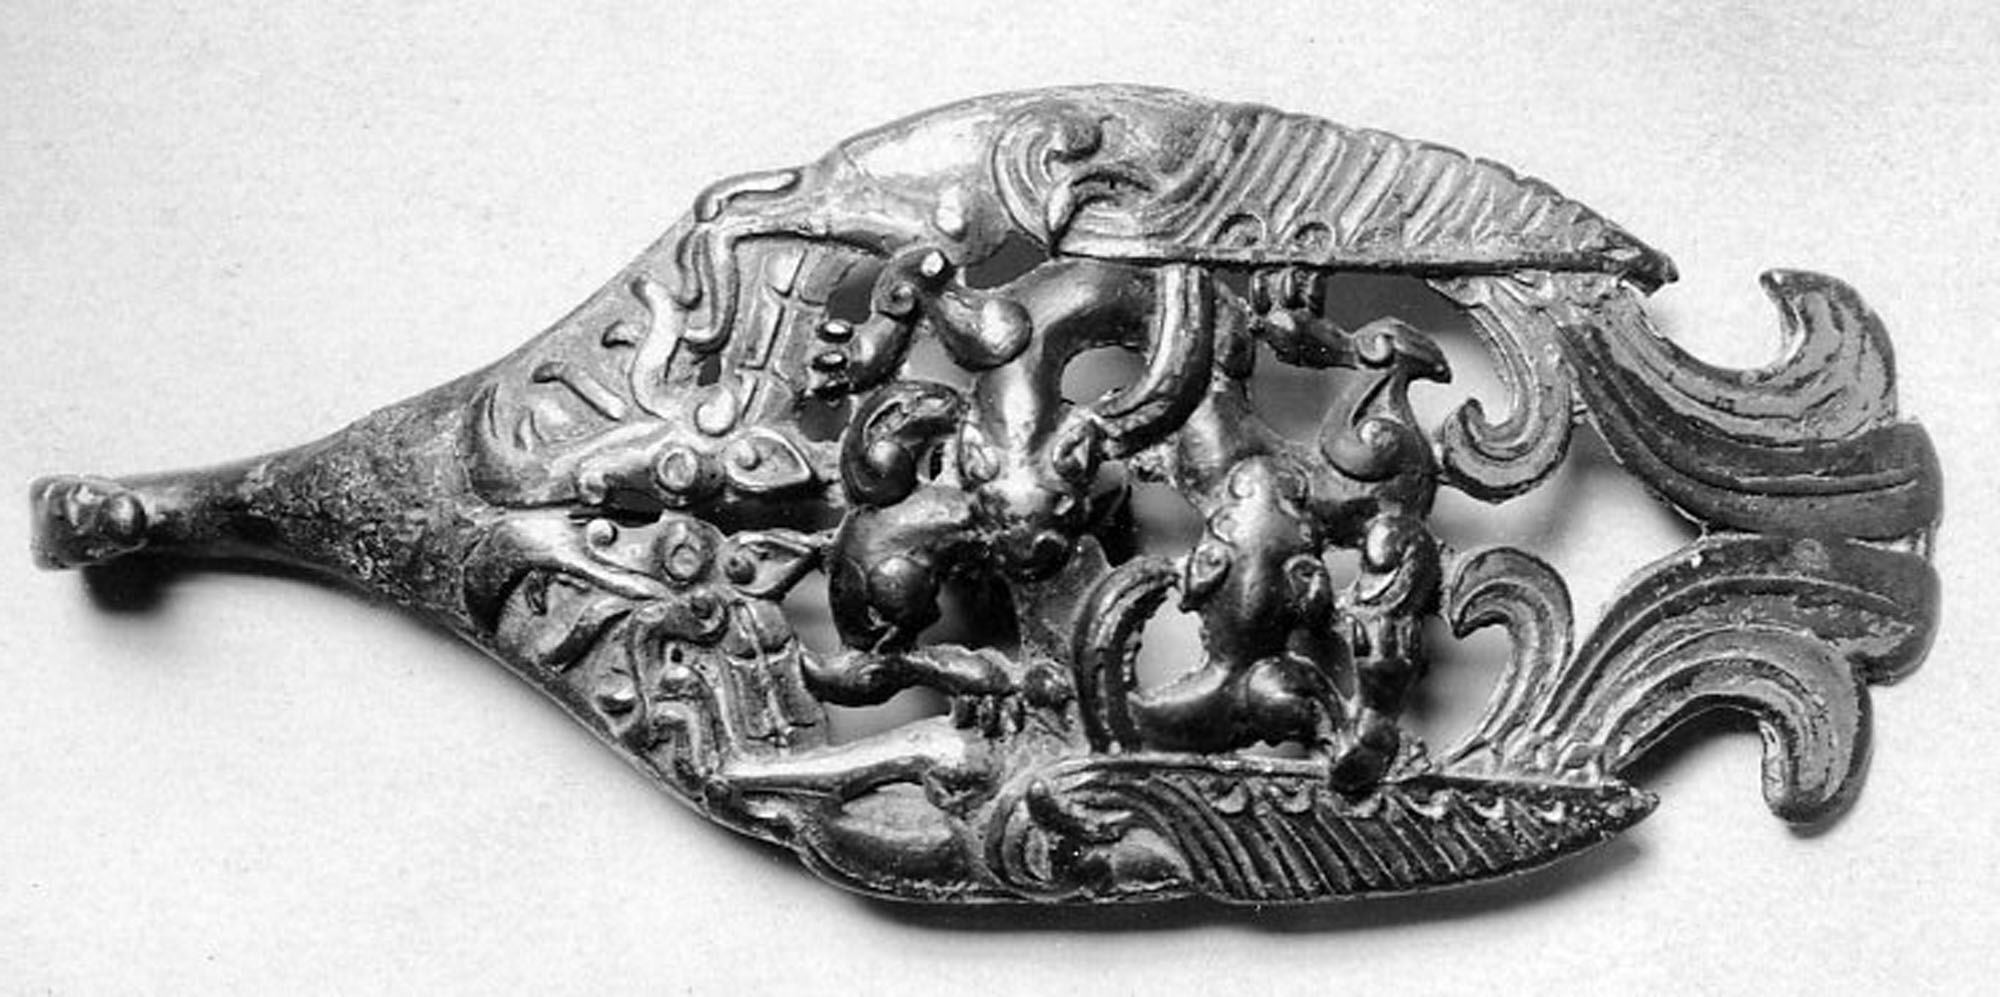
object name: belt buckle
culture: chinese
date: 1801-2000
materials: bronze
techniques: silvered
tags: animals